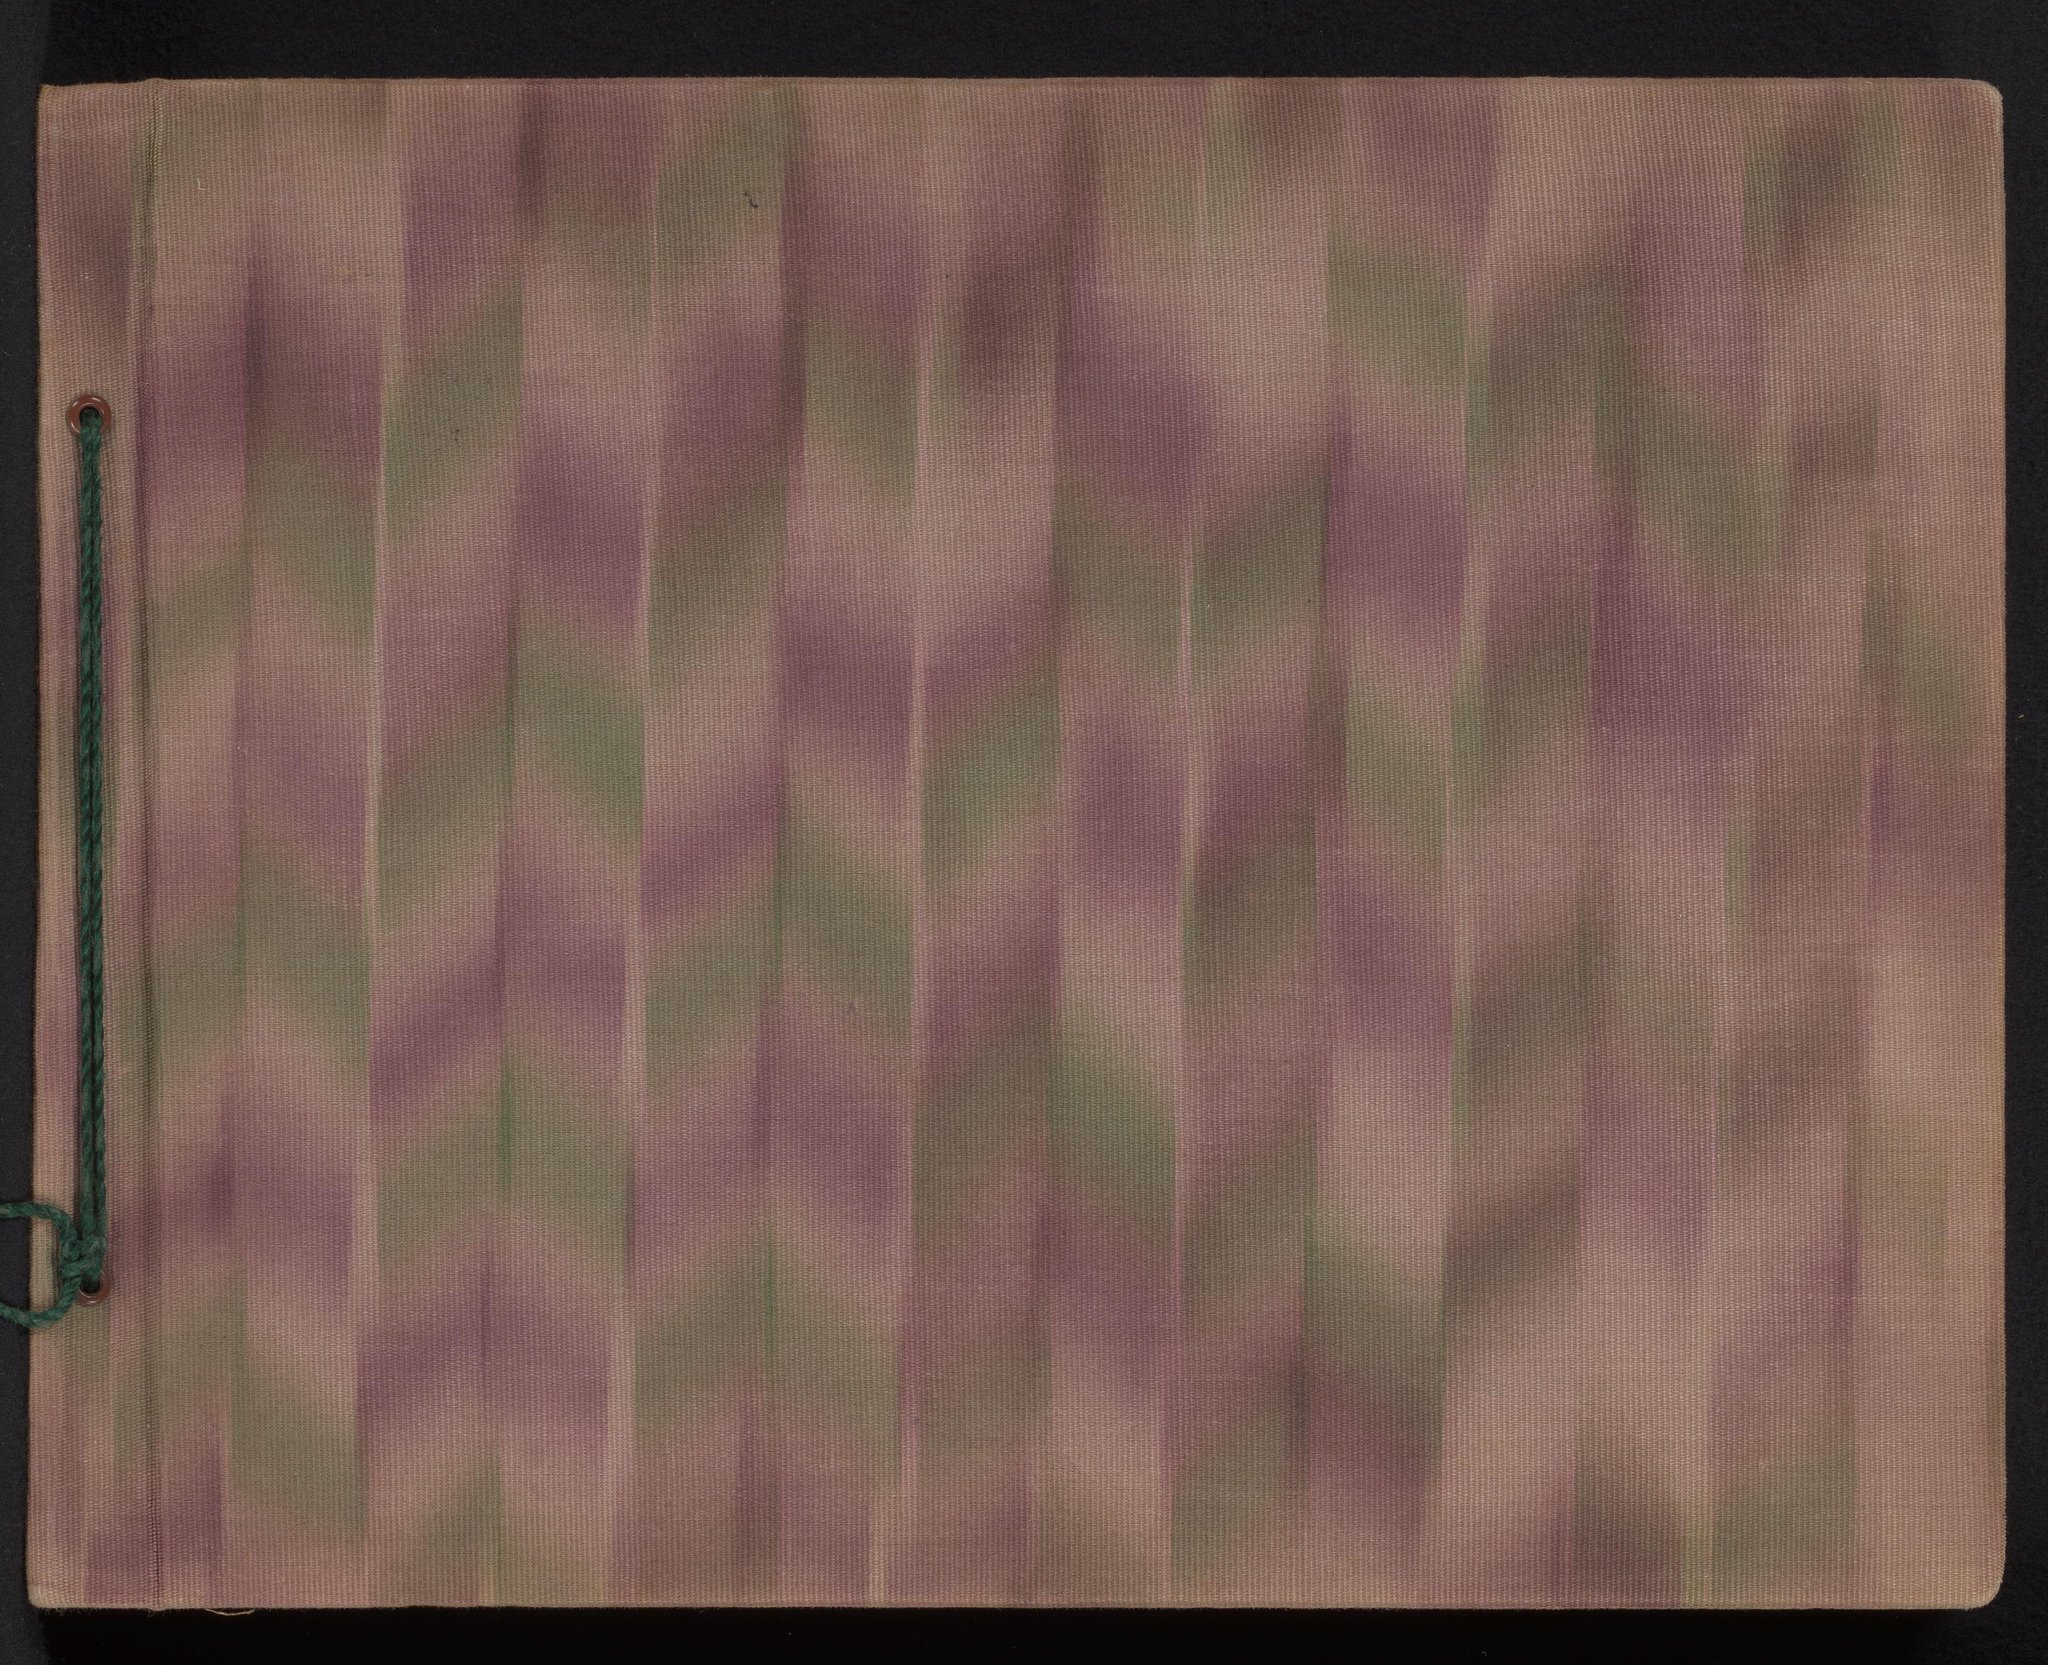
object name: scrapbook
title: Fotoalbum met 234 foto's van een vakantie van Berti Hoppe en Herman Besselaar in Wenen en bezoeken aan andere delen van Oostenrijk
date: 1930-1931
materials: cardboard, cordage, linen, paper, photographic support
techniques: gelatin silver print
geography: austria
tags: herman besselaar, berti hoppe, winter landscape; landscape symbolizing winter (the four seasons of the year), swimming (movement in water), prospect of city, town panorama, silhouette of city, mountains, vienna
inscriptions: retailer's mark: ‘PHOTO-SPEZIALHAUS/ CHRISTOPH SCHALLER/ NFLG JULKUPPER-WIEN/ GETREIDEMARKT/ 14’, company name: ‘REISA’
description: Fotoalbum met 45 pagina's met in totaal 234 foto's van verschillende vakanties van Berti Hoppe en Herman Besselaar naar Wenen, Hainburg an der Donau, Semmering, de Oostenrijkse Alpen en andere plaatsen in Oostenrijk. Het album is door Berti Hoppe samengesteld als herinnering aan Oostenrijk toen zij emigreerde naar Nederland en zij is mogelijk ook de fotograaf van een groot deel van de foto's. Van de foto's waarop Berti is te zien, is de fotograaf anoniem. Dit album is onderdeel van vijf albums van de Besselaars.